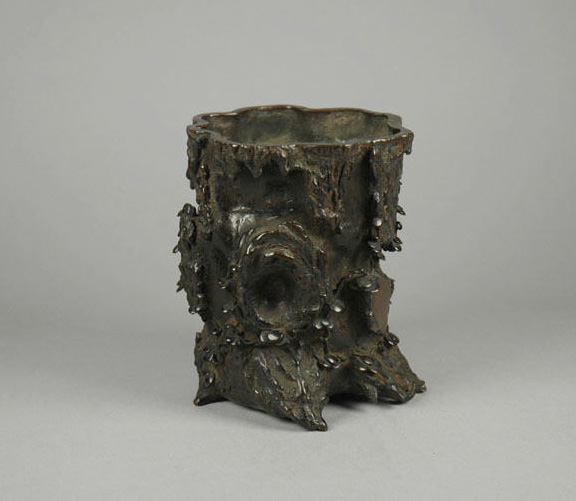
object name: brush holder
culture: japanese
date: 1801-1900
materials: bronze